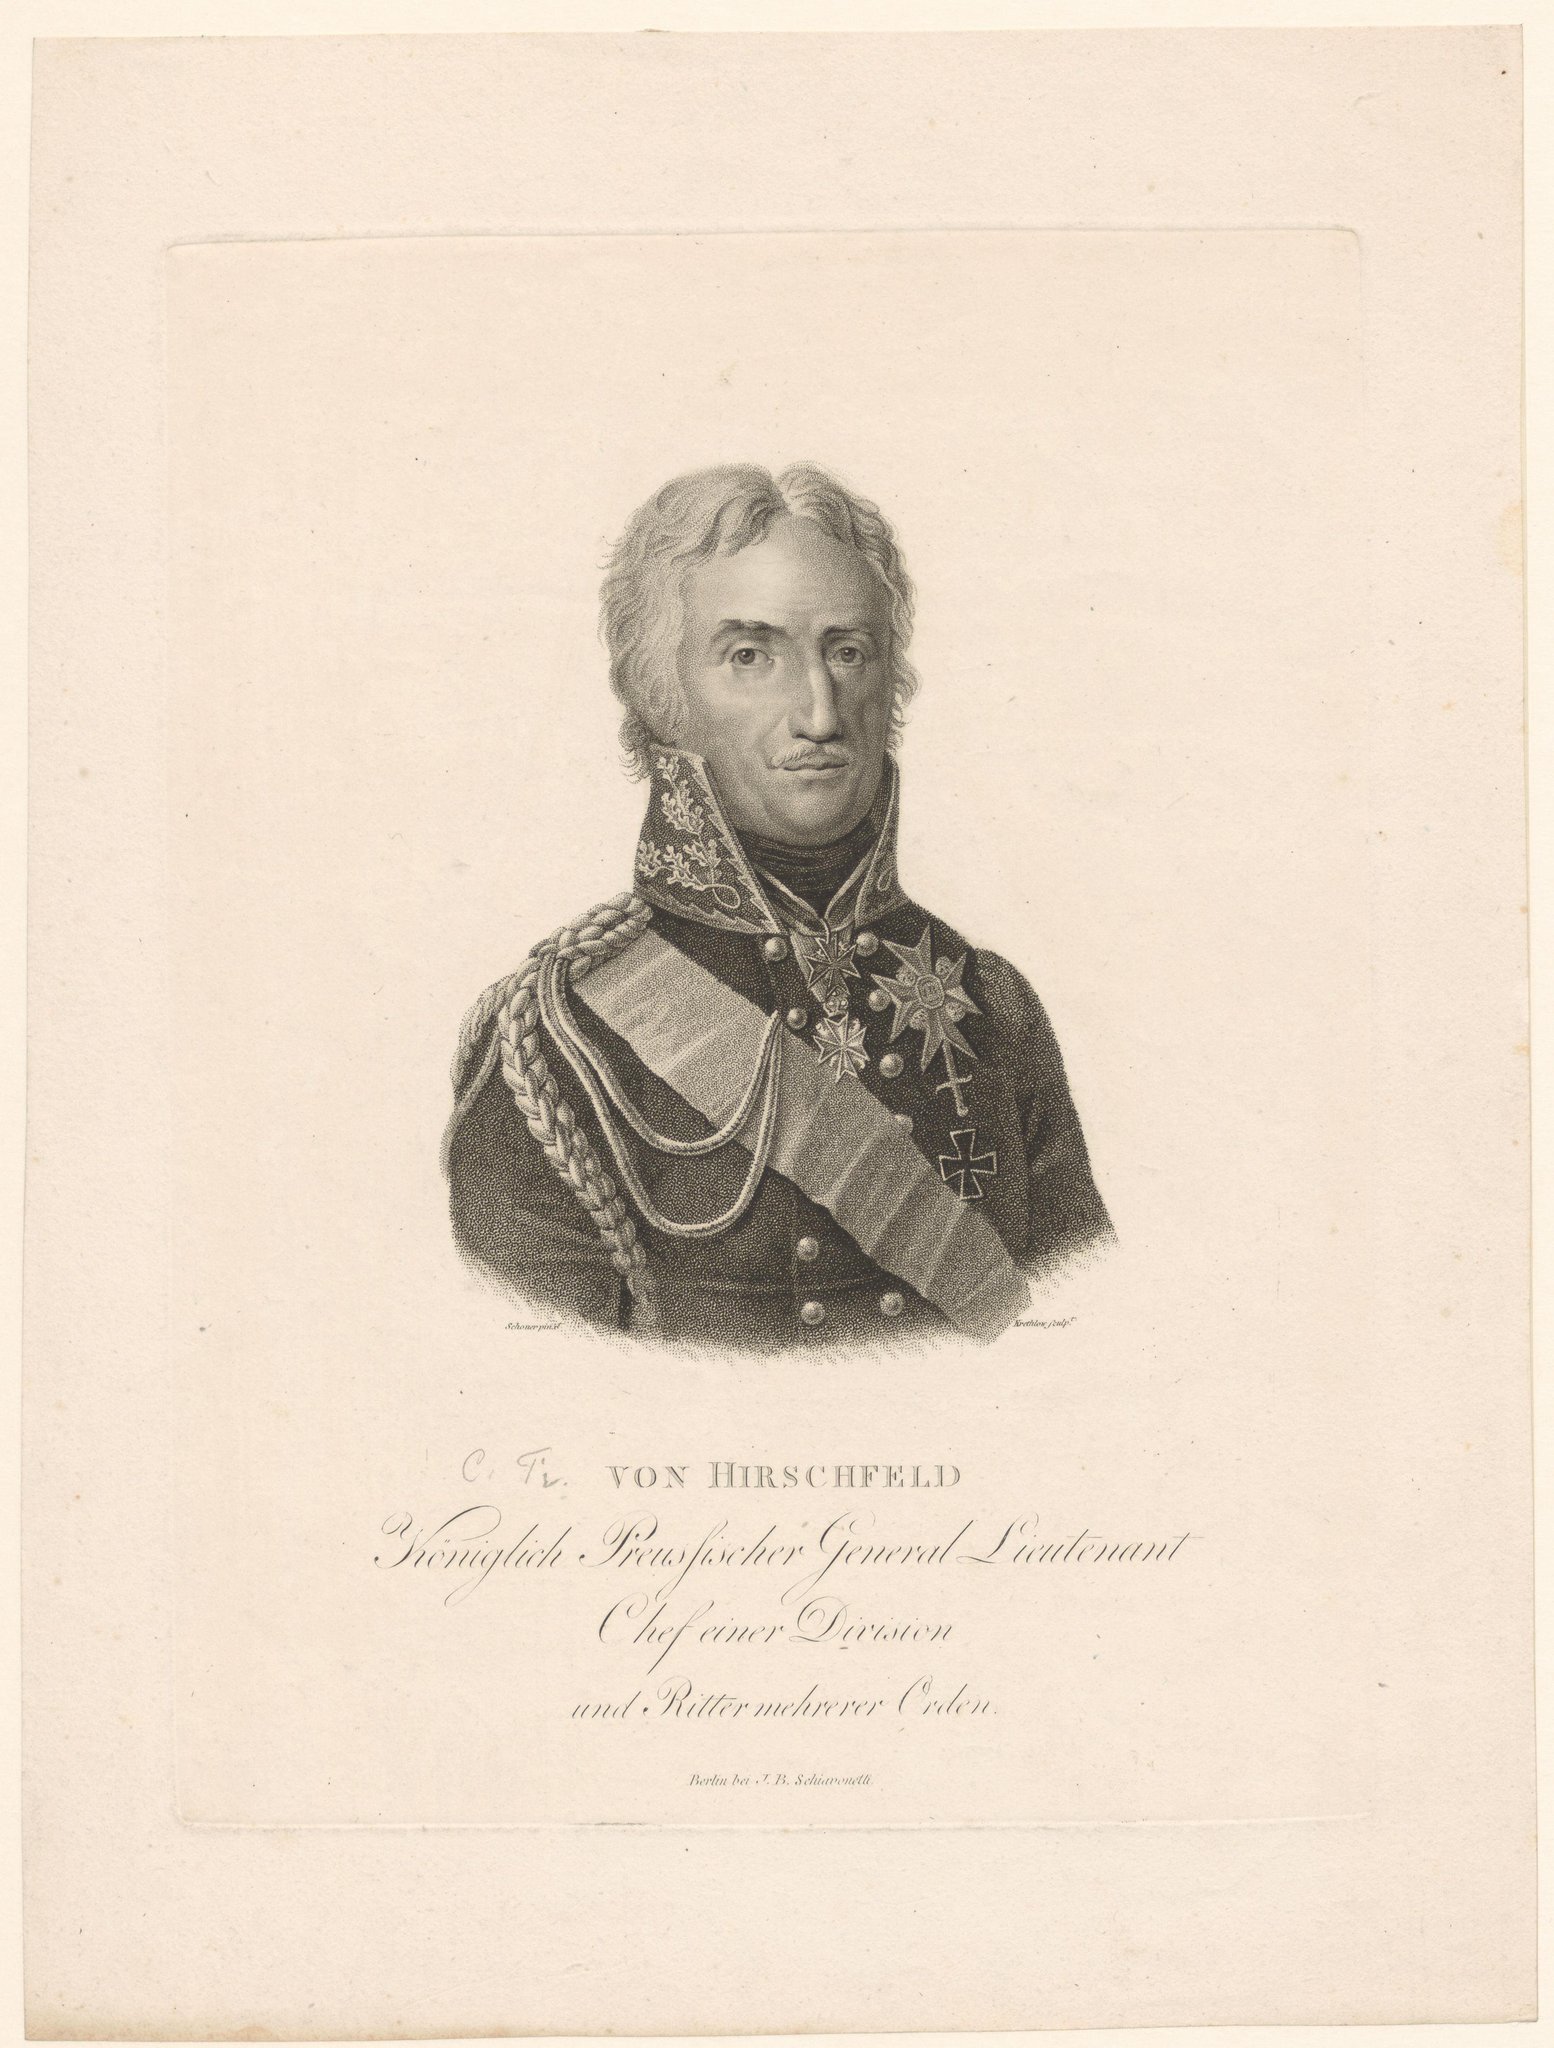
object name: print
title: Portret van Karl Friedrich von Hirschfeld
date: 1800-1840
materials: paper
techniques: stippling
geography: berlin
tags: knighthood order: teutonic order - insignia of a knighthood order, e.g.: badge, chain (with name of order), knighthood order (with name) - insignia of a knighthood order, e.g.: badge, chain (with name of order), commander-in-chief, general, marshal, historical persons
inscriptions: collector's mark: Lugt 2228